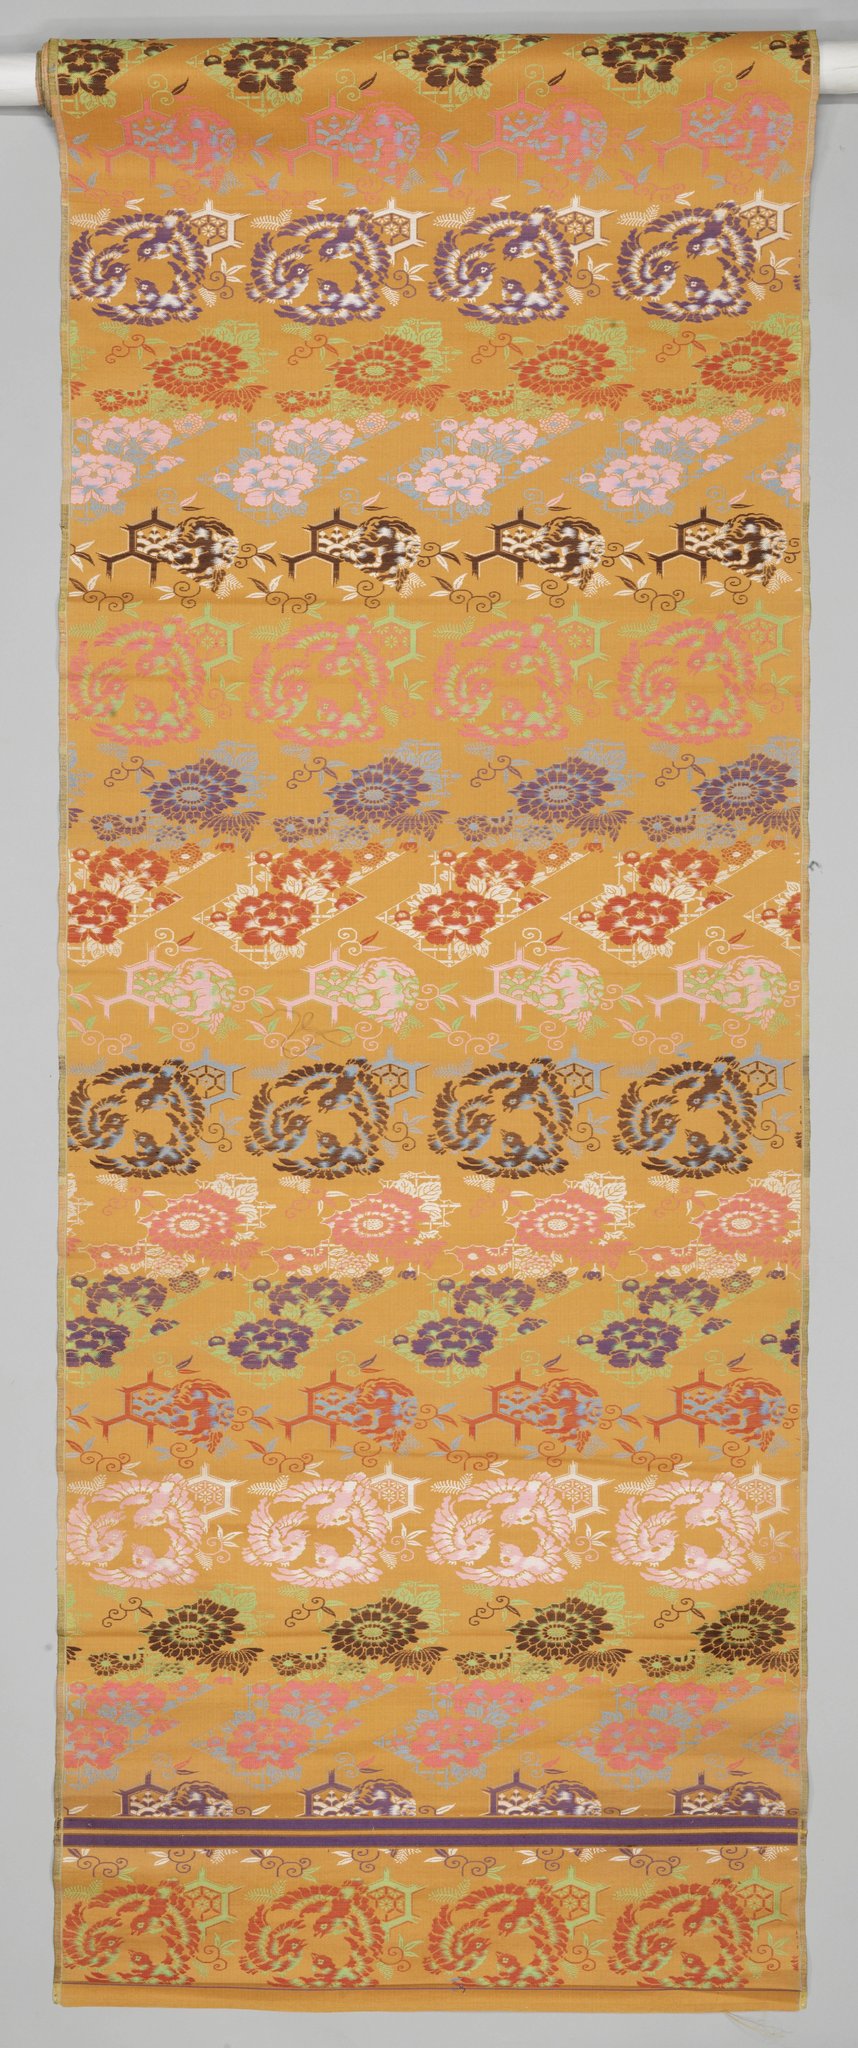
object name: baan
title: Baan zijde met een dessin van afwisselend bloemen, bloemen op rasterwerk, haas naast zeshoek en vogels in cirkel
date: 1900-1920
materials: silk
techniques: weave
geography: japan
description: Baan zijde met dessin van afwisselend bloemen, bloemen tegen rasterwerk, haas naast zeshoek en vogels in cirkel in blauw, bruin, roze, wit, paars, groen en rood op oranje fond. Oosters textiel.